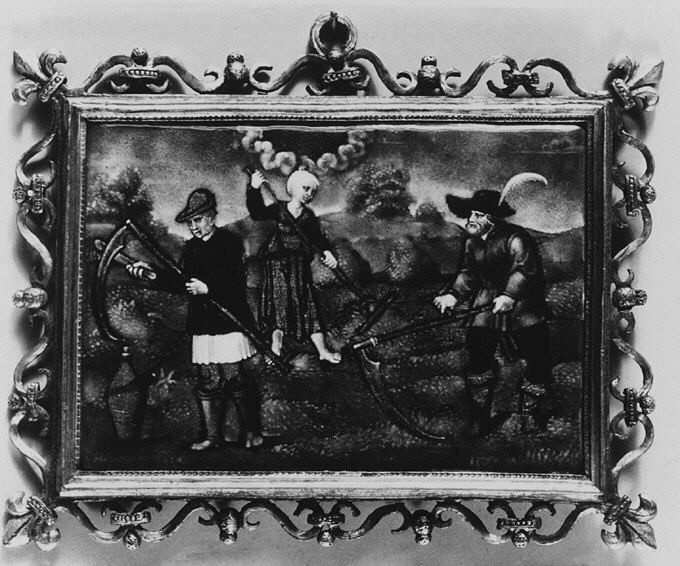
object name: plaque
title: Labors of the Months: Haymaking (July)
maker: jean ii pénicaud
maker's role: maker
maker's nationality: french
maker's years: 1524-1554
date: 1534-1566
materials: copper, enamel, gilt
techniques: painting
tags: men,women,working